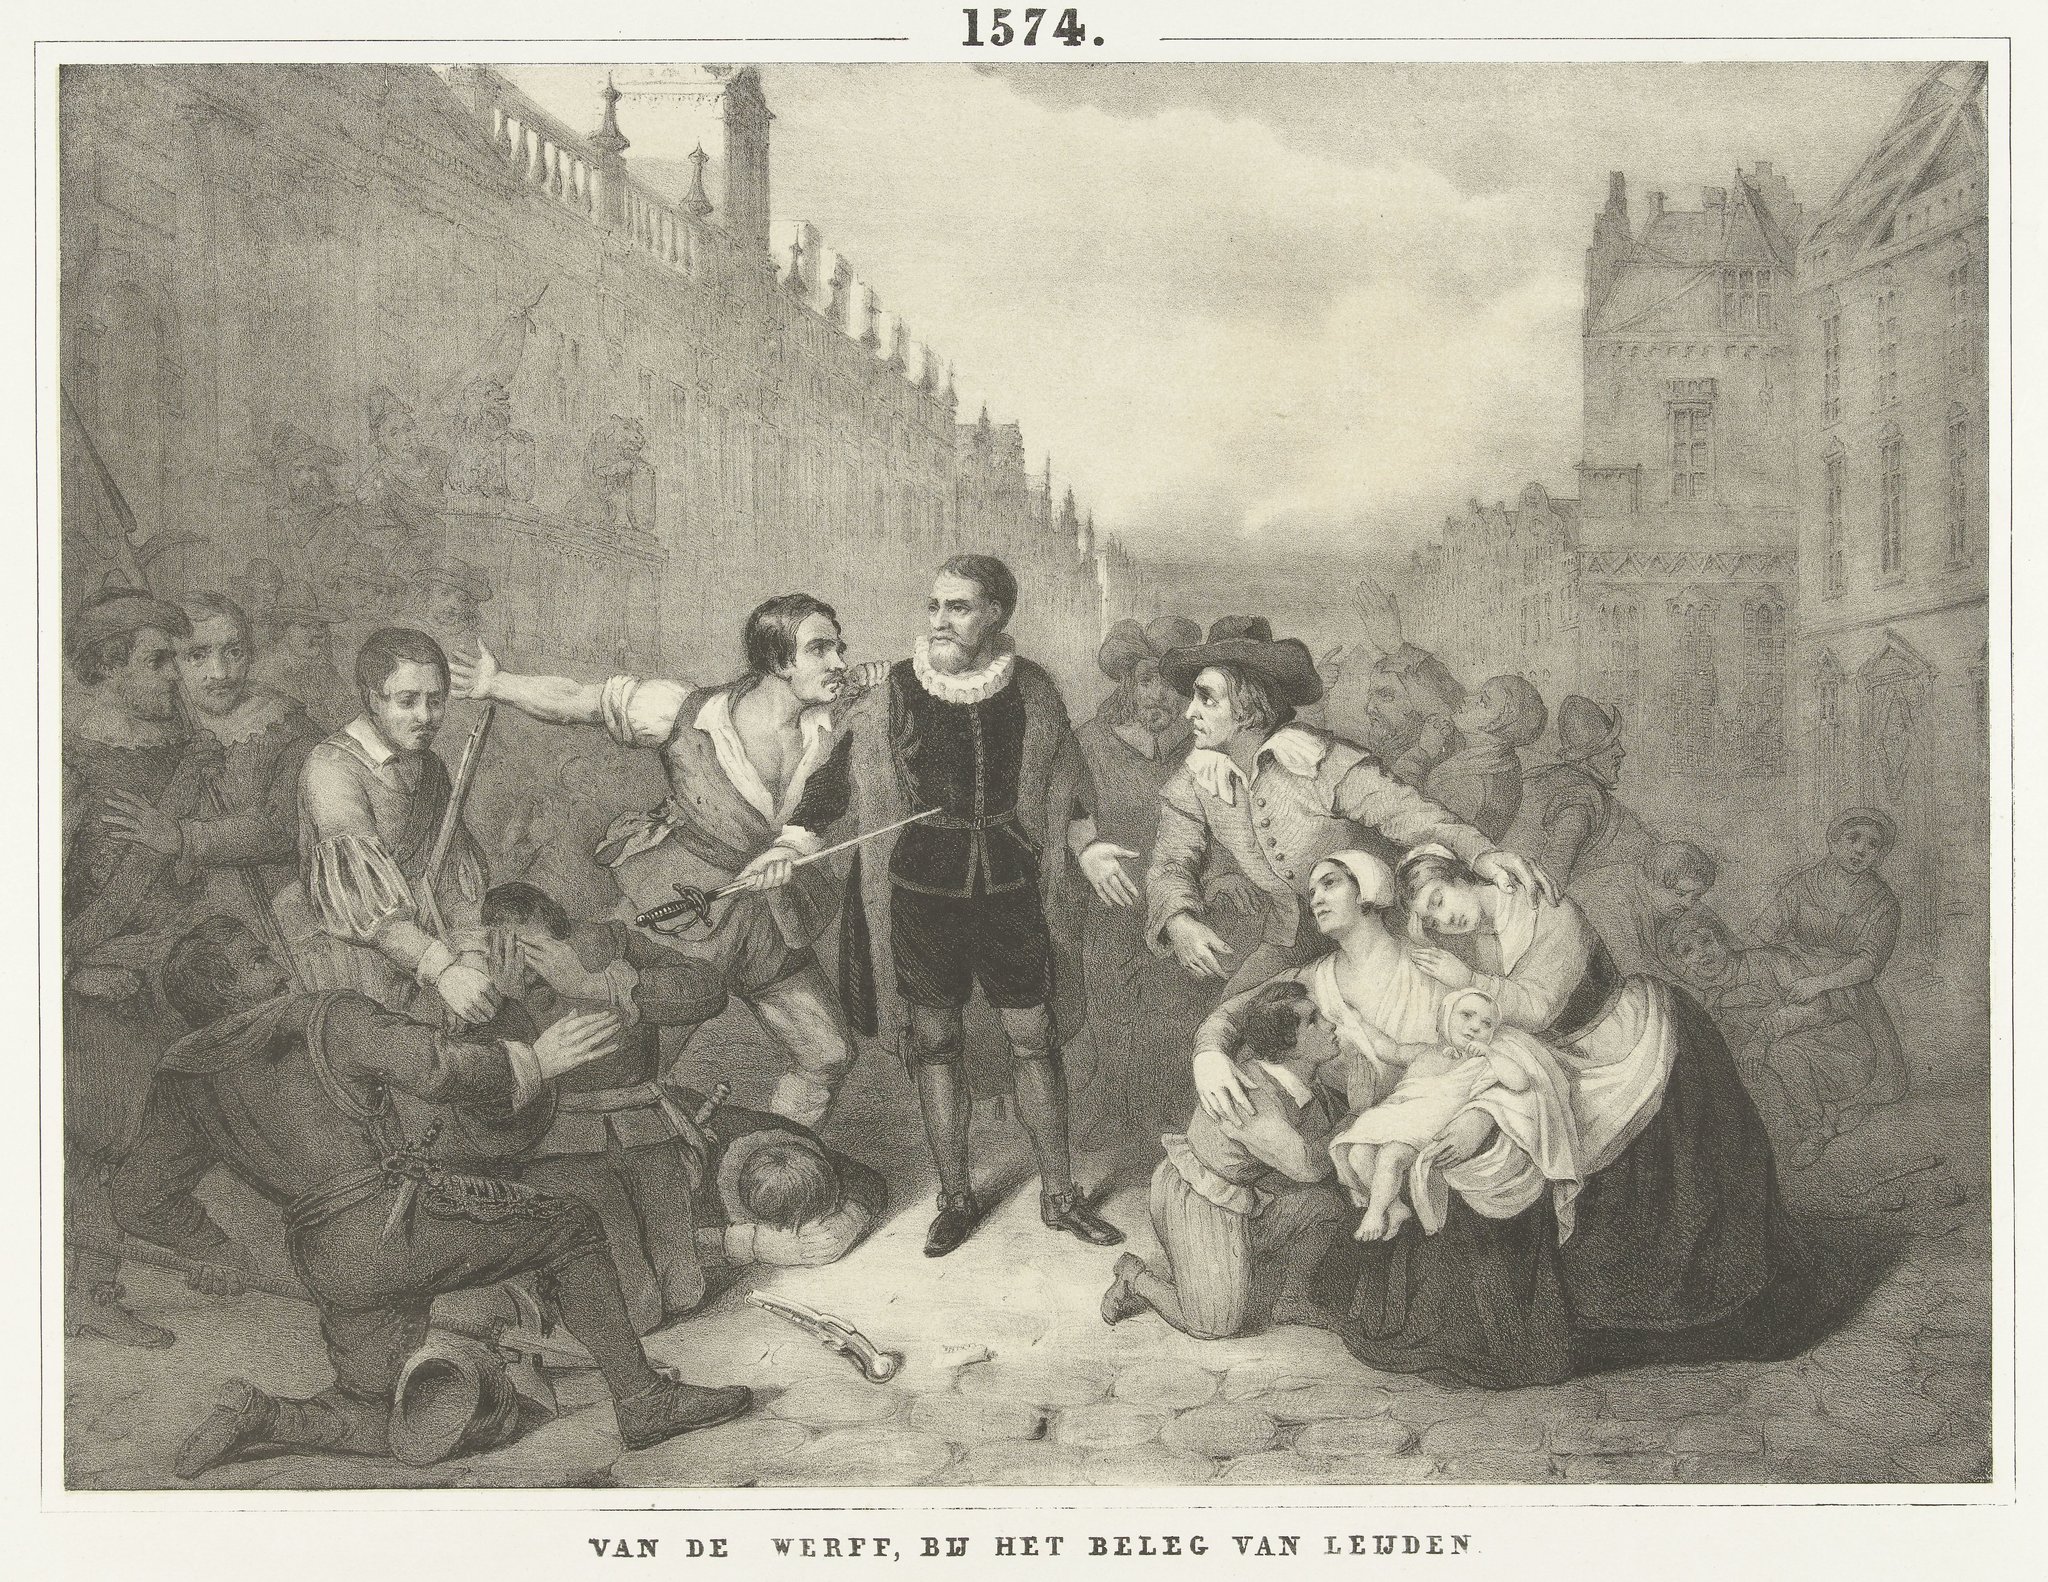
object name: print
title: 1574 / Van de Werff, bij het beleg van Leijden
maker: Anonymous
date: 1853-1855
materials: paper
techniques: lithograph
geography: netherlands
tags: leiden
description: Naar het schilderij van G. Wappers van 1829 in de collectie van het Centraal Museum te Utrecht. Gebruikt als illustratie in: J.H. Eichman & H. Altmann, Vaderlandsche historieplaten voor scholen en huisgezinnen, Leiden, 1855. Dit nummer is een door het RPK toegevoegd nummer en staat niet in Frederik Muller, het werk waar de prent voor is gemaakt of uit afkomstig is, staat wel vermeld in Frederik Muller.